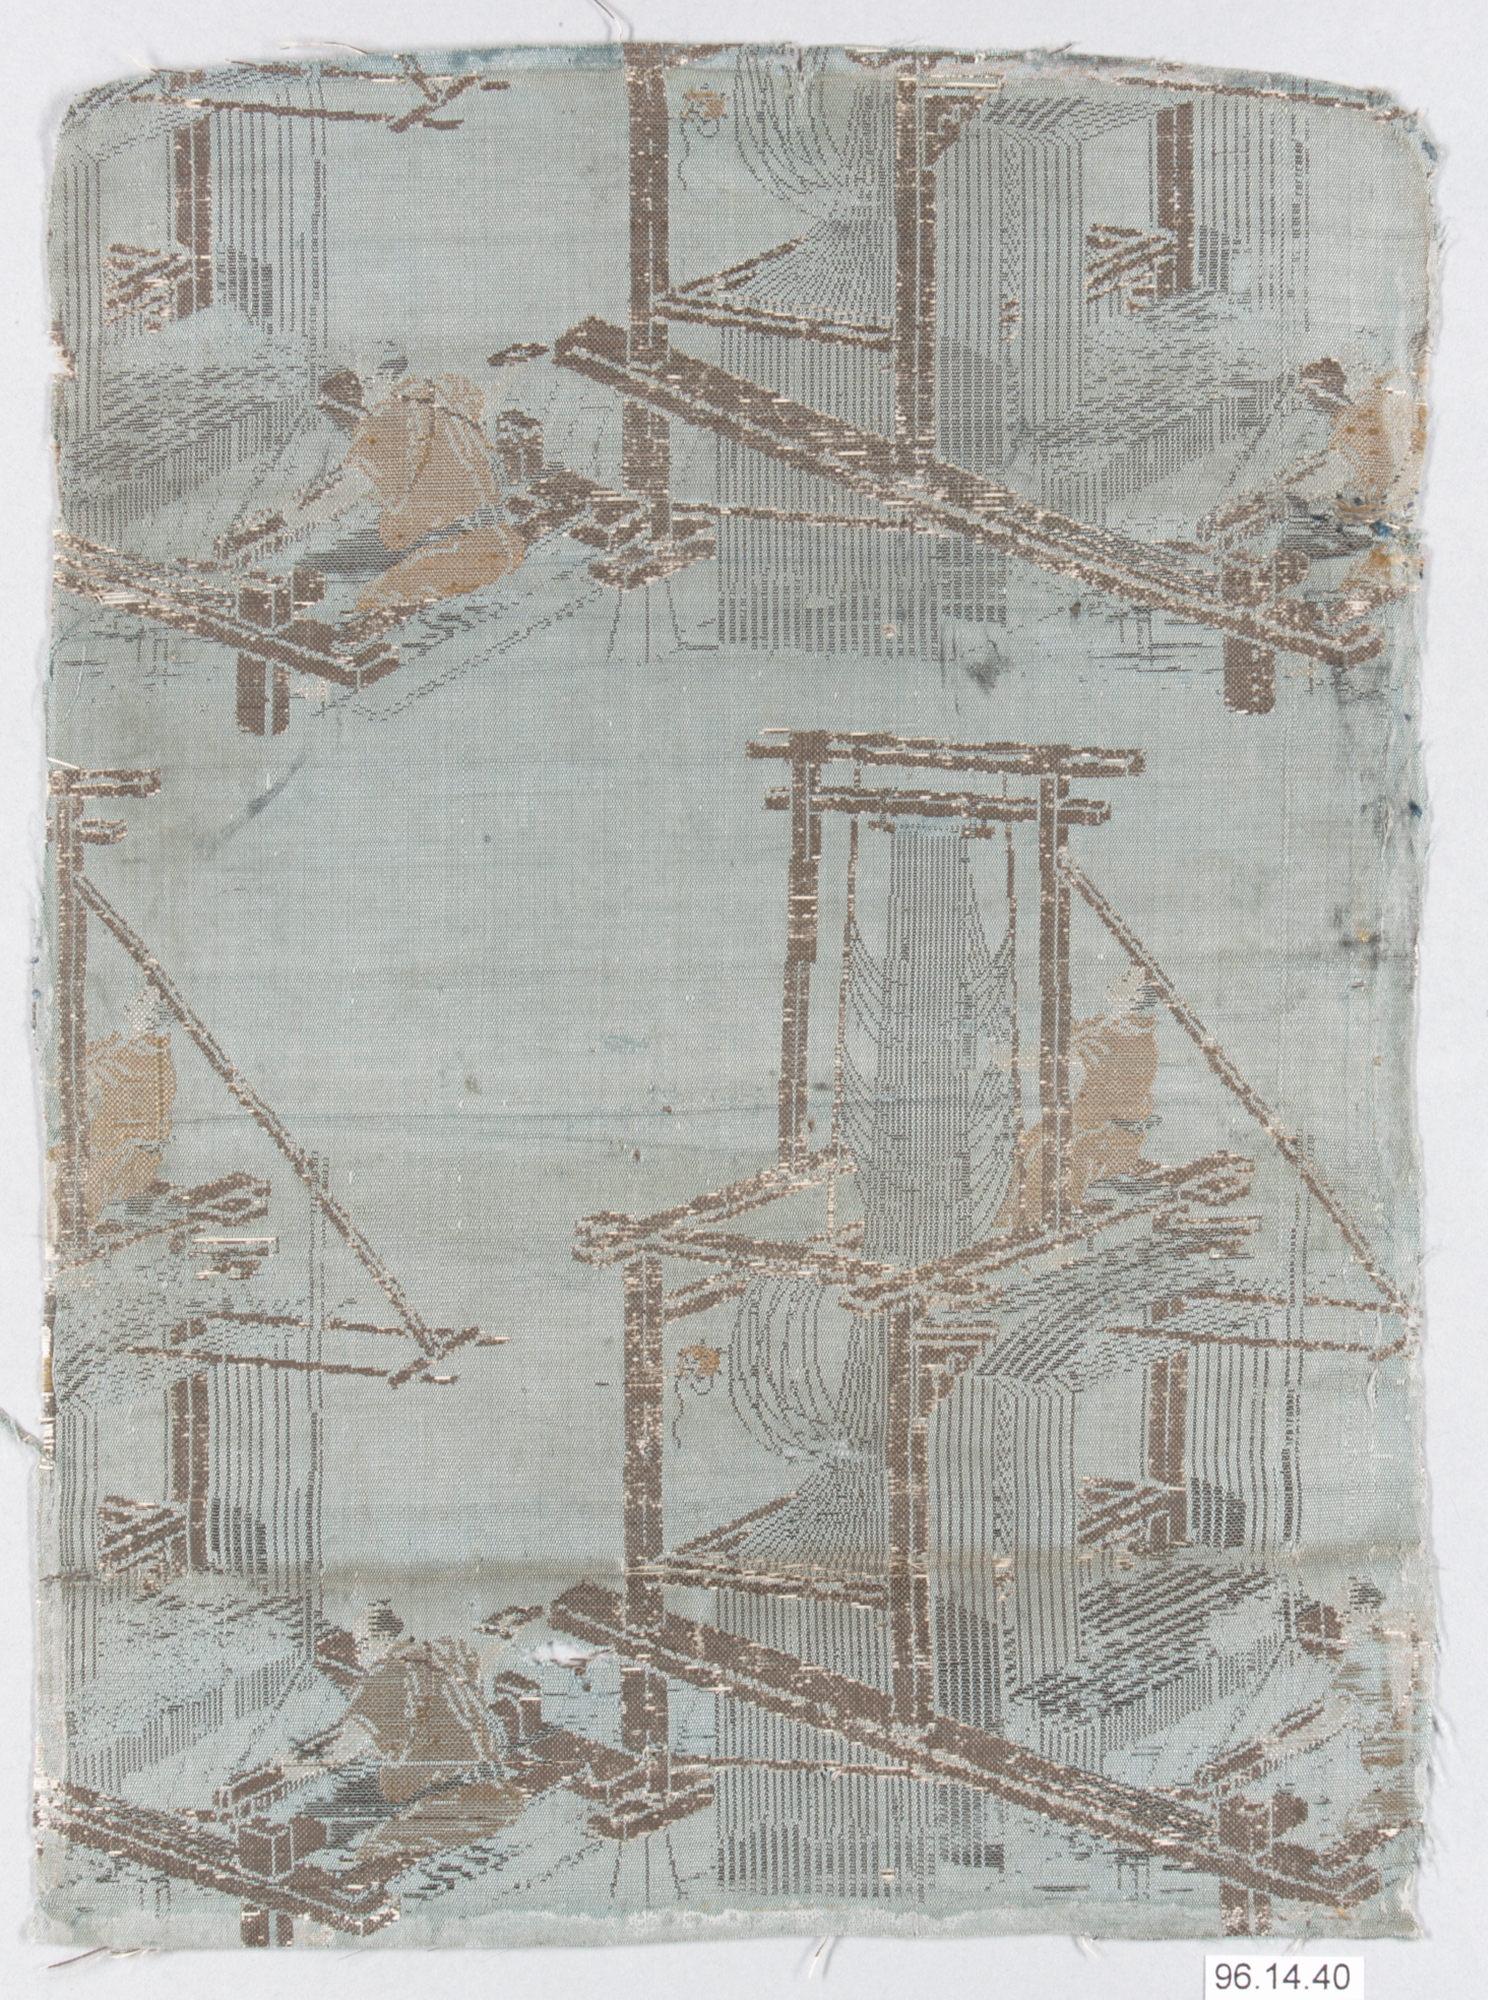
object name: fragment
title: Textile fragment with incomplete repeating pattern of loom, weaver, and drawboy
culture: japanese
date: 1801-1850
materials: silk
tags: working,looms